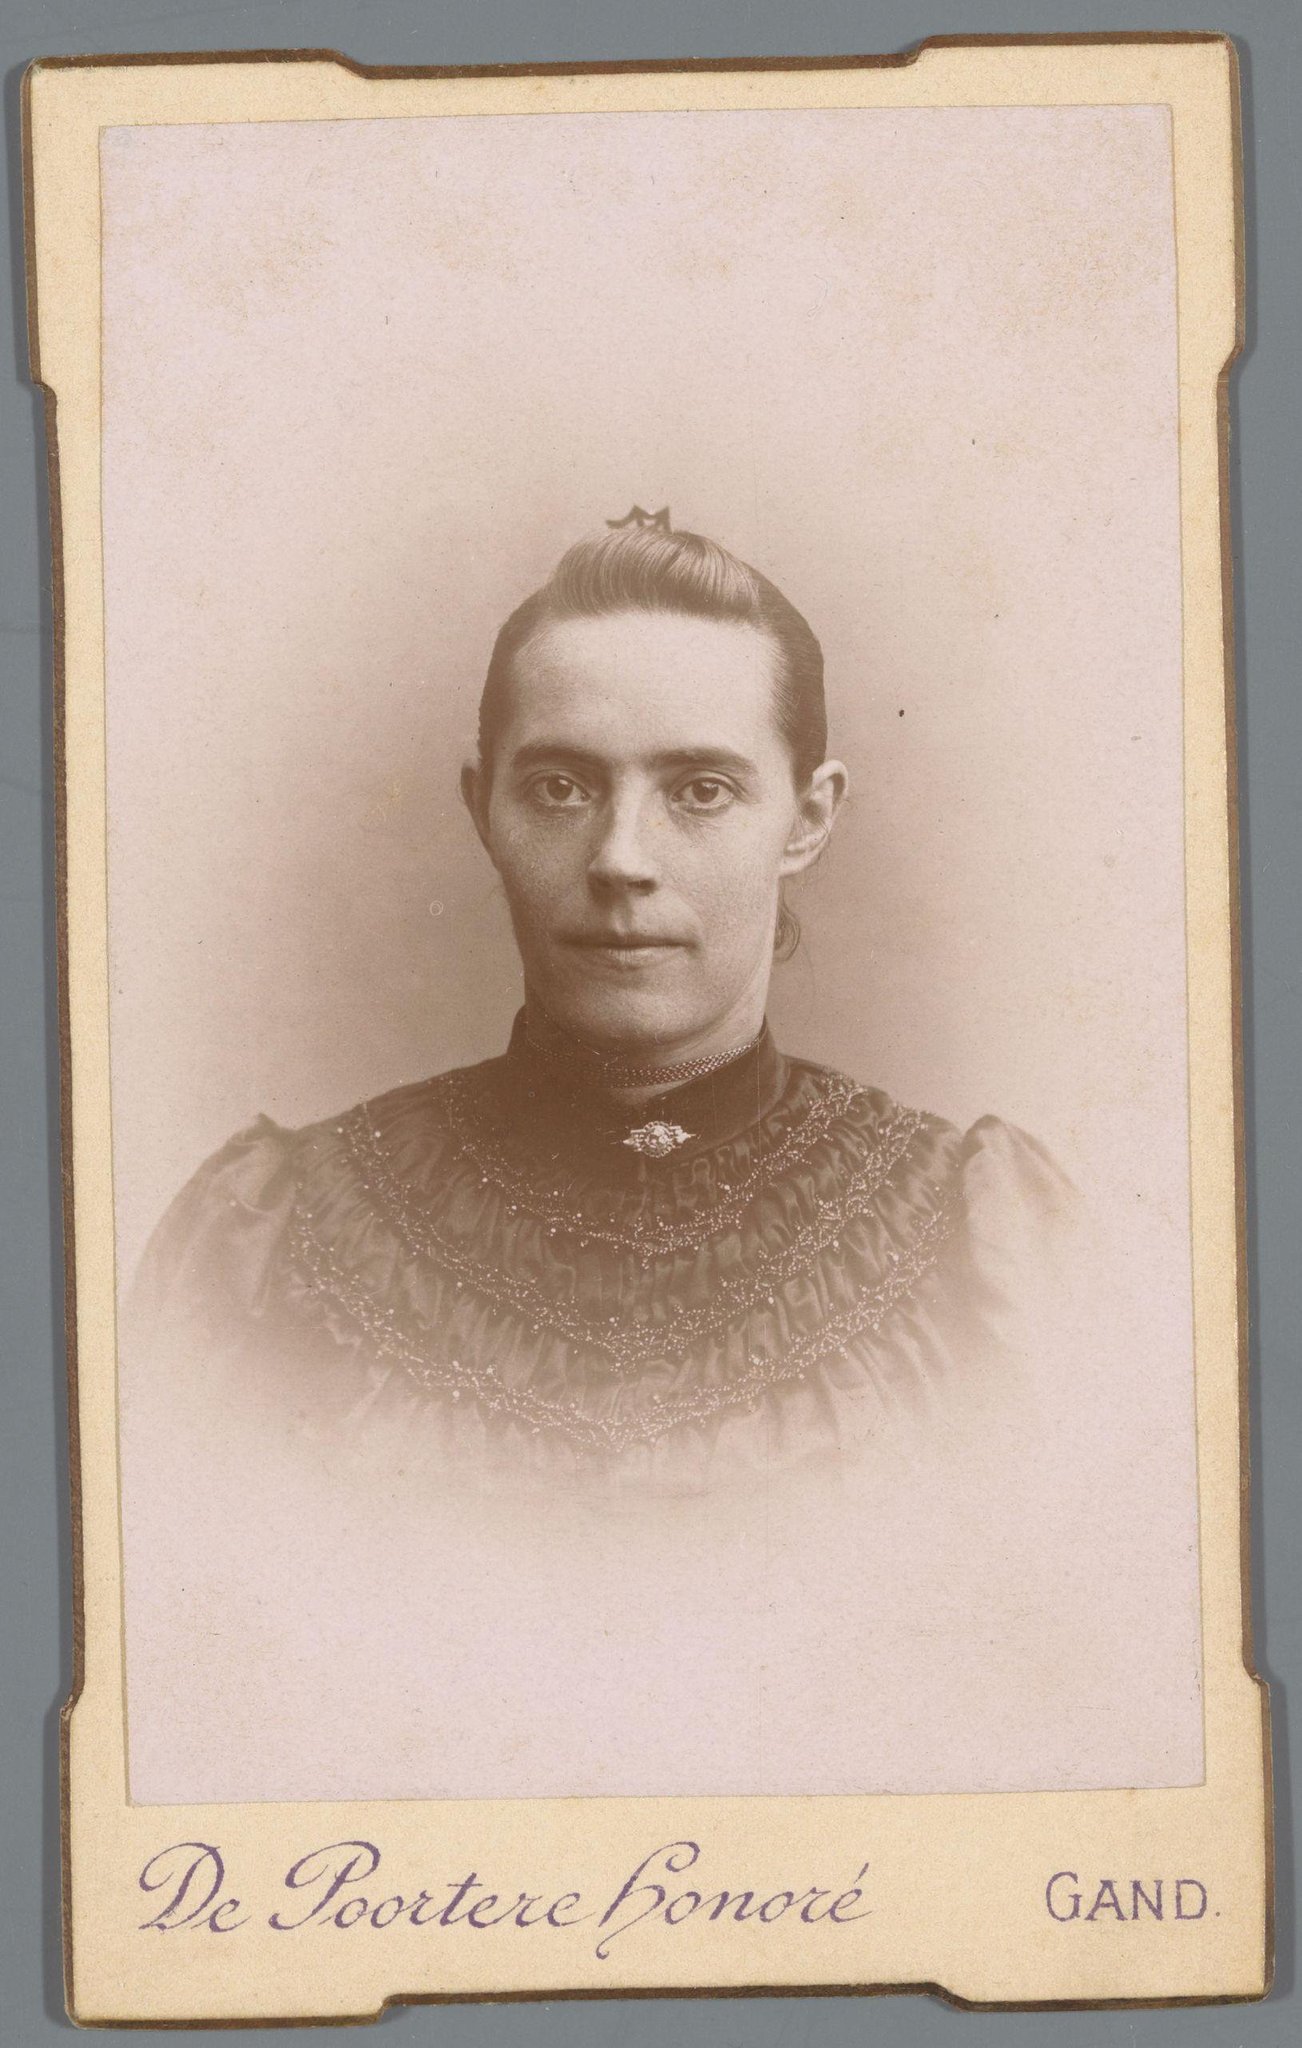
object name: photograph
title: Portret van een onbekende vrouw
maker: honoré de poortere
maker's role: fotograaf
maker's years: 1870-1949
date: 1895-1903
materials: paper, cardboard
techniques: collodion silver print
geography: ghent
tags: adult woman, anonymous historical person portrayed, ghent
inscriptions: inscription: ‘De Poortere Honoré Gand.’, inscription: ‘De Poortere Honoré/ 57, Rue des remouleurs/ Slypstraat 57, Gand/ Gent/ Atelier chez rez de Chaussée./ Posserkamer beneden./ Les clichés sont conservés./ De cliches blyven bewaard/ Bernhard Wachtl Vienne.’